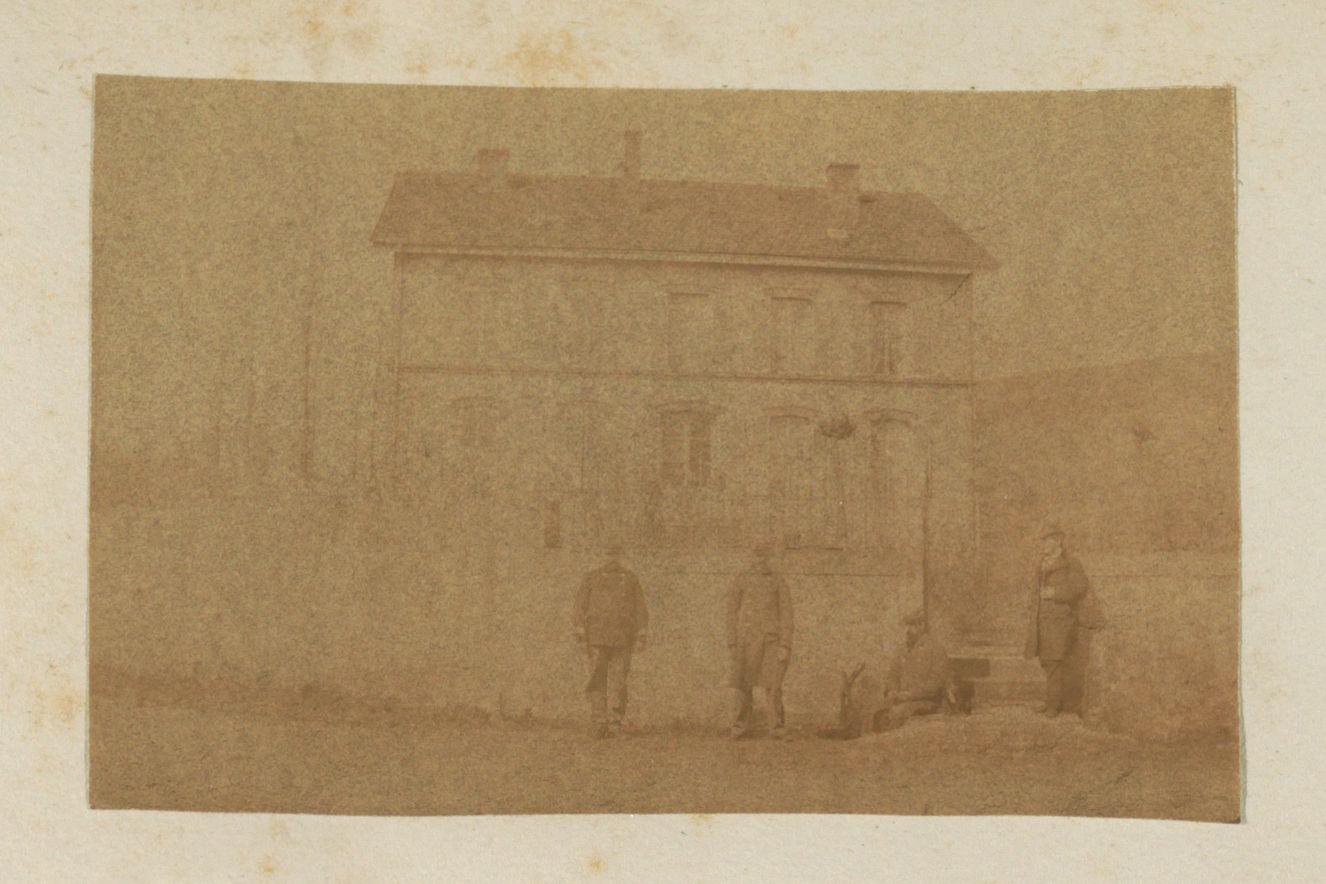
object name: photograph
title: Vier mannen voor een huis in Frankrijk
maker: Anonymous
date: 1883-1886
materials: photographic support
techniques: albumen print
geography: france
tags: rural housing, e.g. country-house, villa, cottage, france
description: Onderdeel van Album van een Franse amateurfotograaf met opnames van familie, militairen, industrie, landschappen en bezienswaardigheden in Frankrijk.